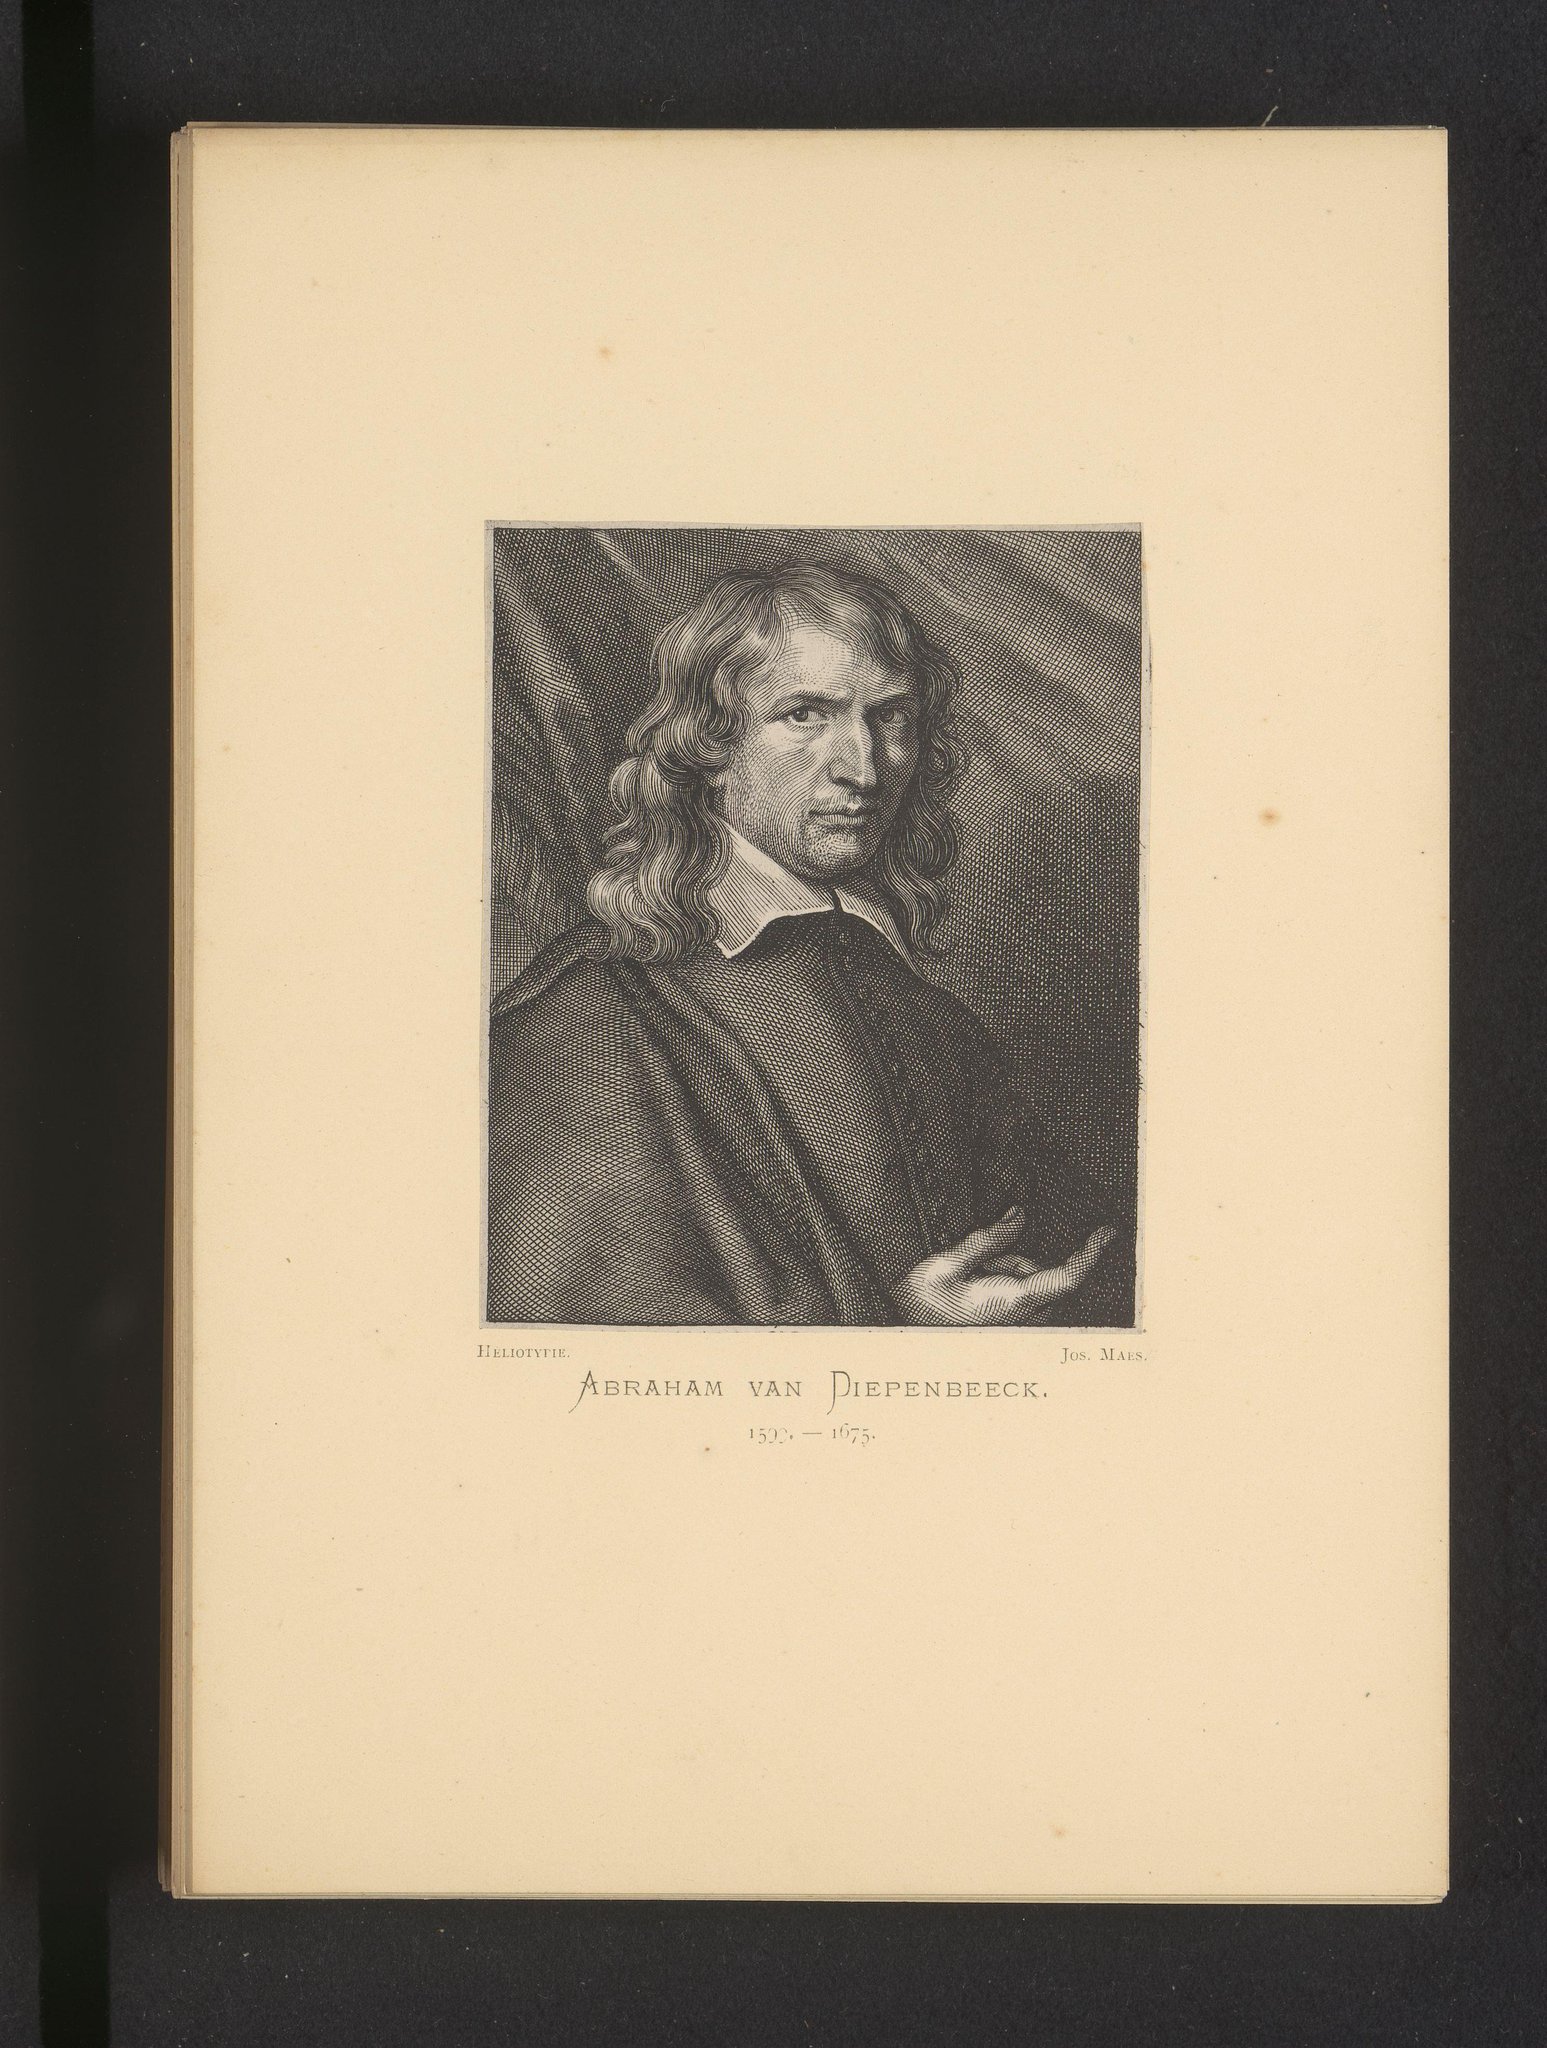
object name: photomechanical print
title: Abraham van Diepenbeeck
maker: joseph maes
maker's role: fotograaf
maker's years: 1838-1908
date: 1872-1877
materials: cardboard, paper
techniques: photograph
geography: antwerp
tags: antwerp, print maker, draughtsman, abraham van diepenbeeck, historical persons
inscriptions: inscription: ‘1599. - 1675.’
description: Deze prent maakt deel uit van een omslag met 150 prenten en een katern met een lijst van afbeeldingen.